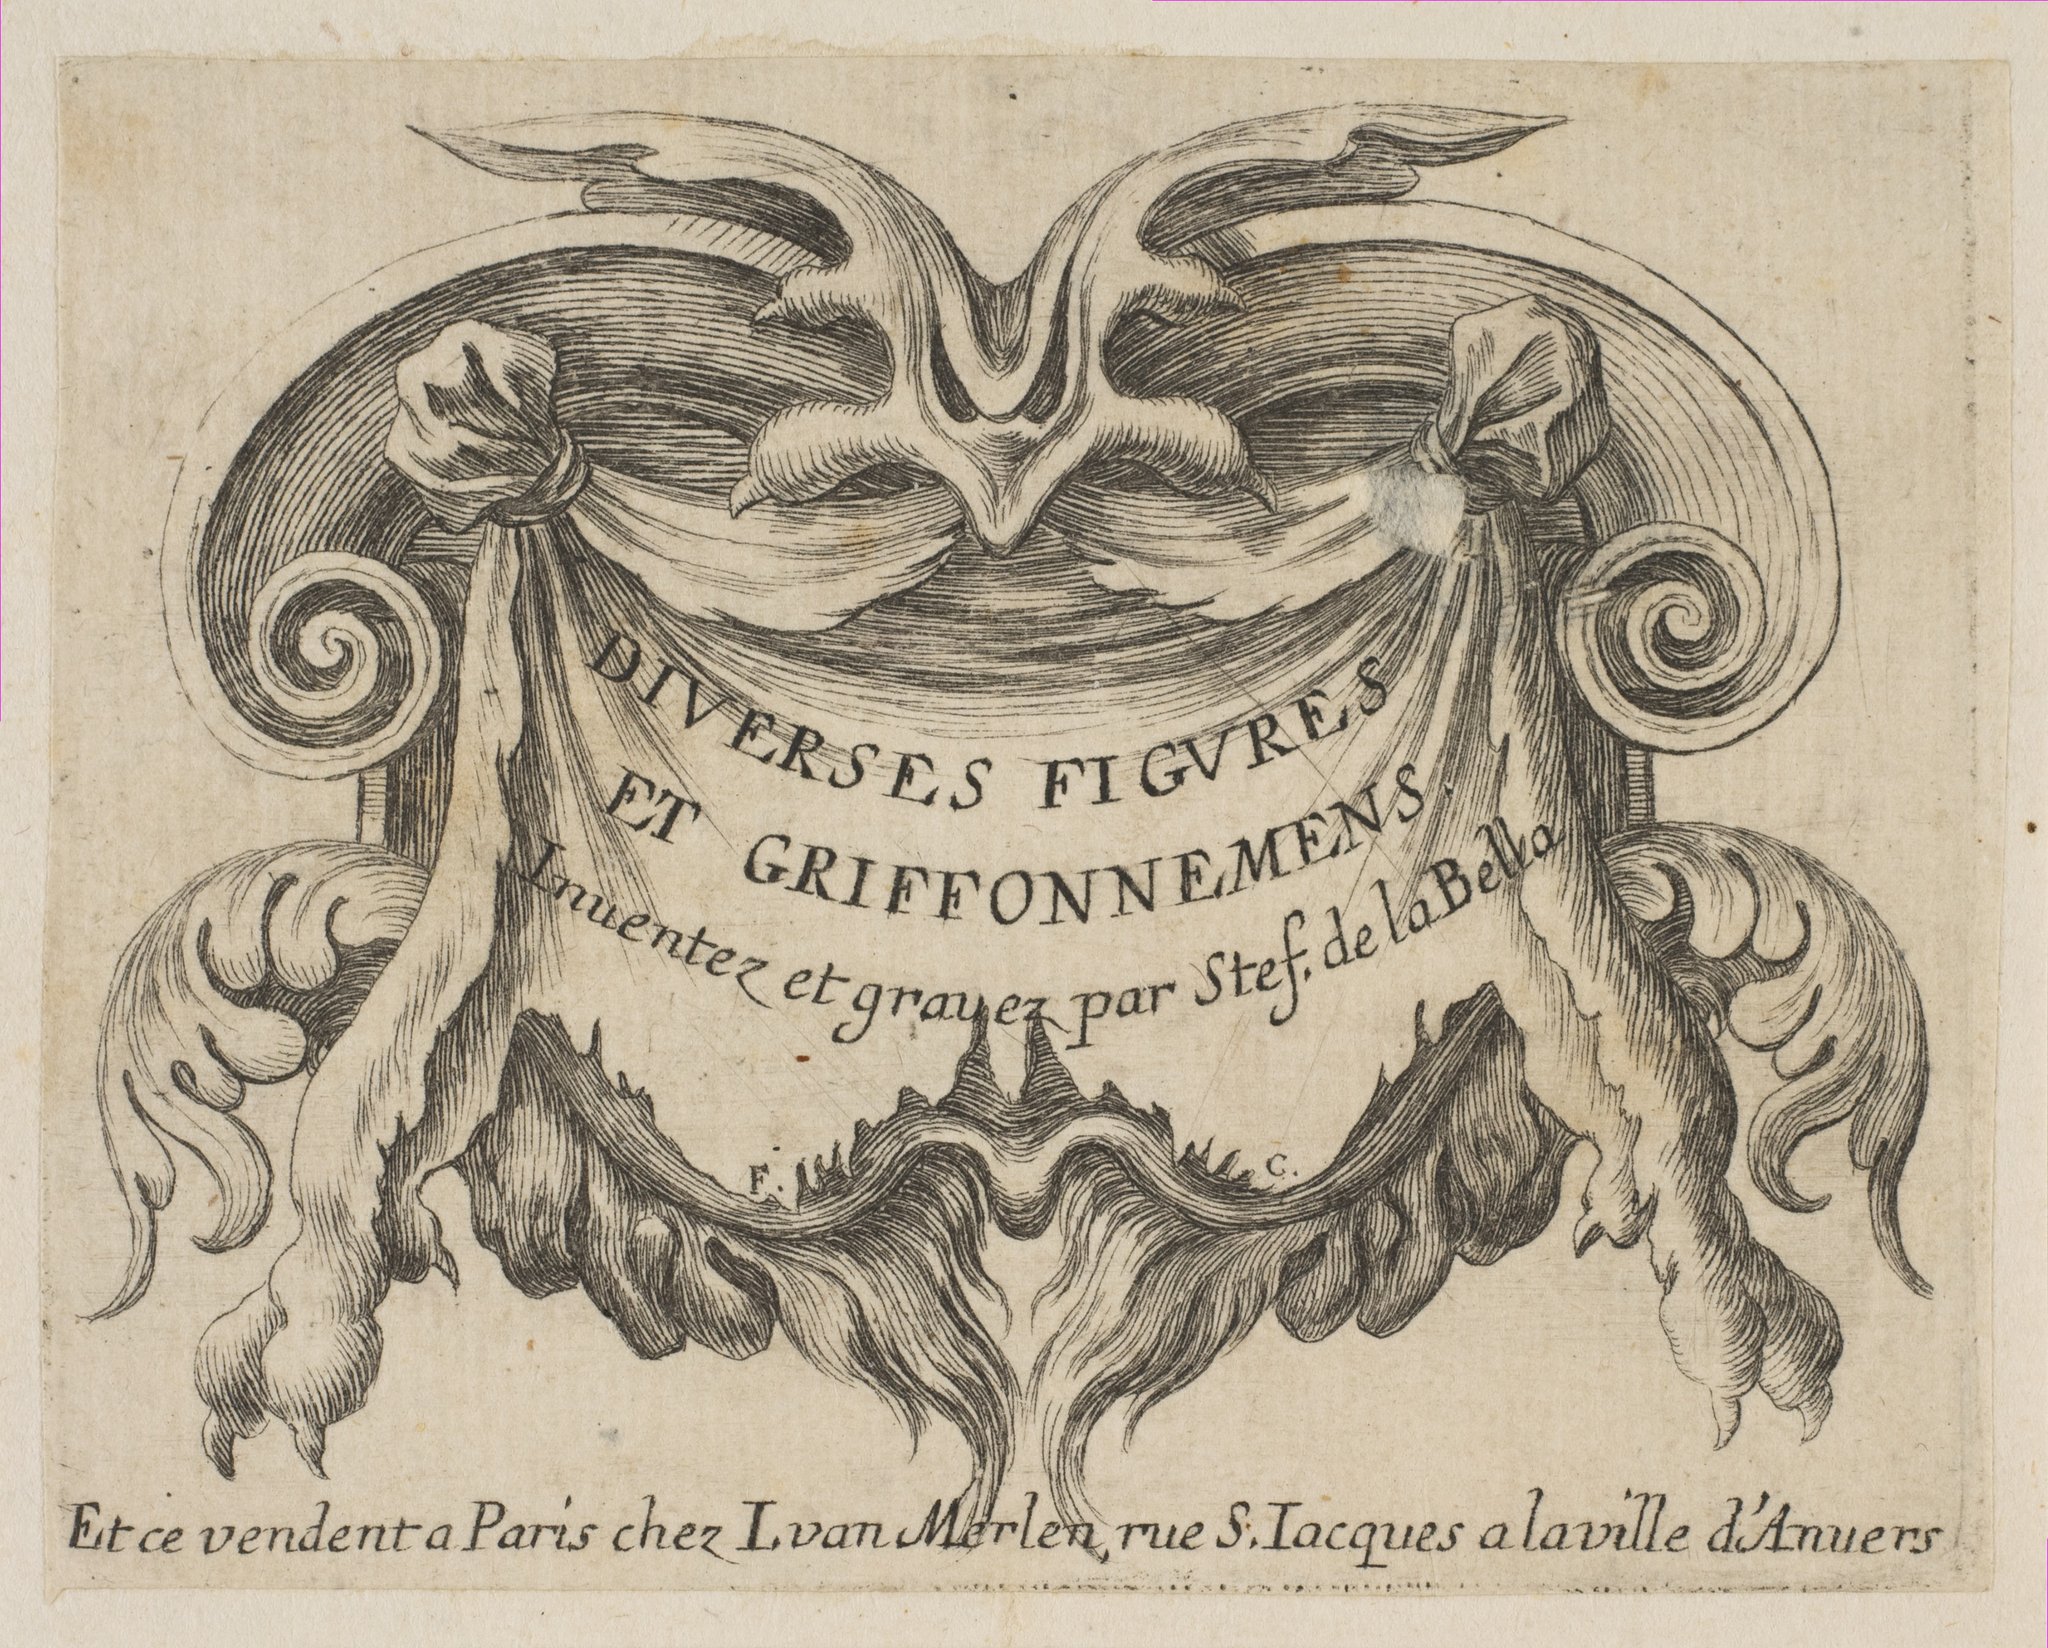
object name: print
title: Title page, from 'Various figures and doodles' (Diverses figures et griffonnemens)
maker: stefano della bella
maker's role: artist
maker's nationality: italian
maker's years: 1610-1664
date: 1646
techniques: etching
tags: cartouches